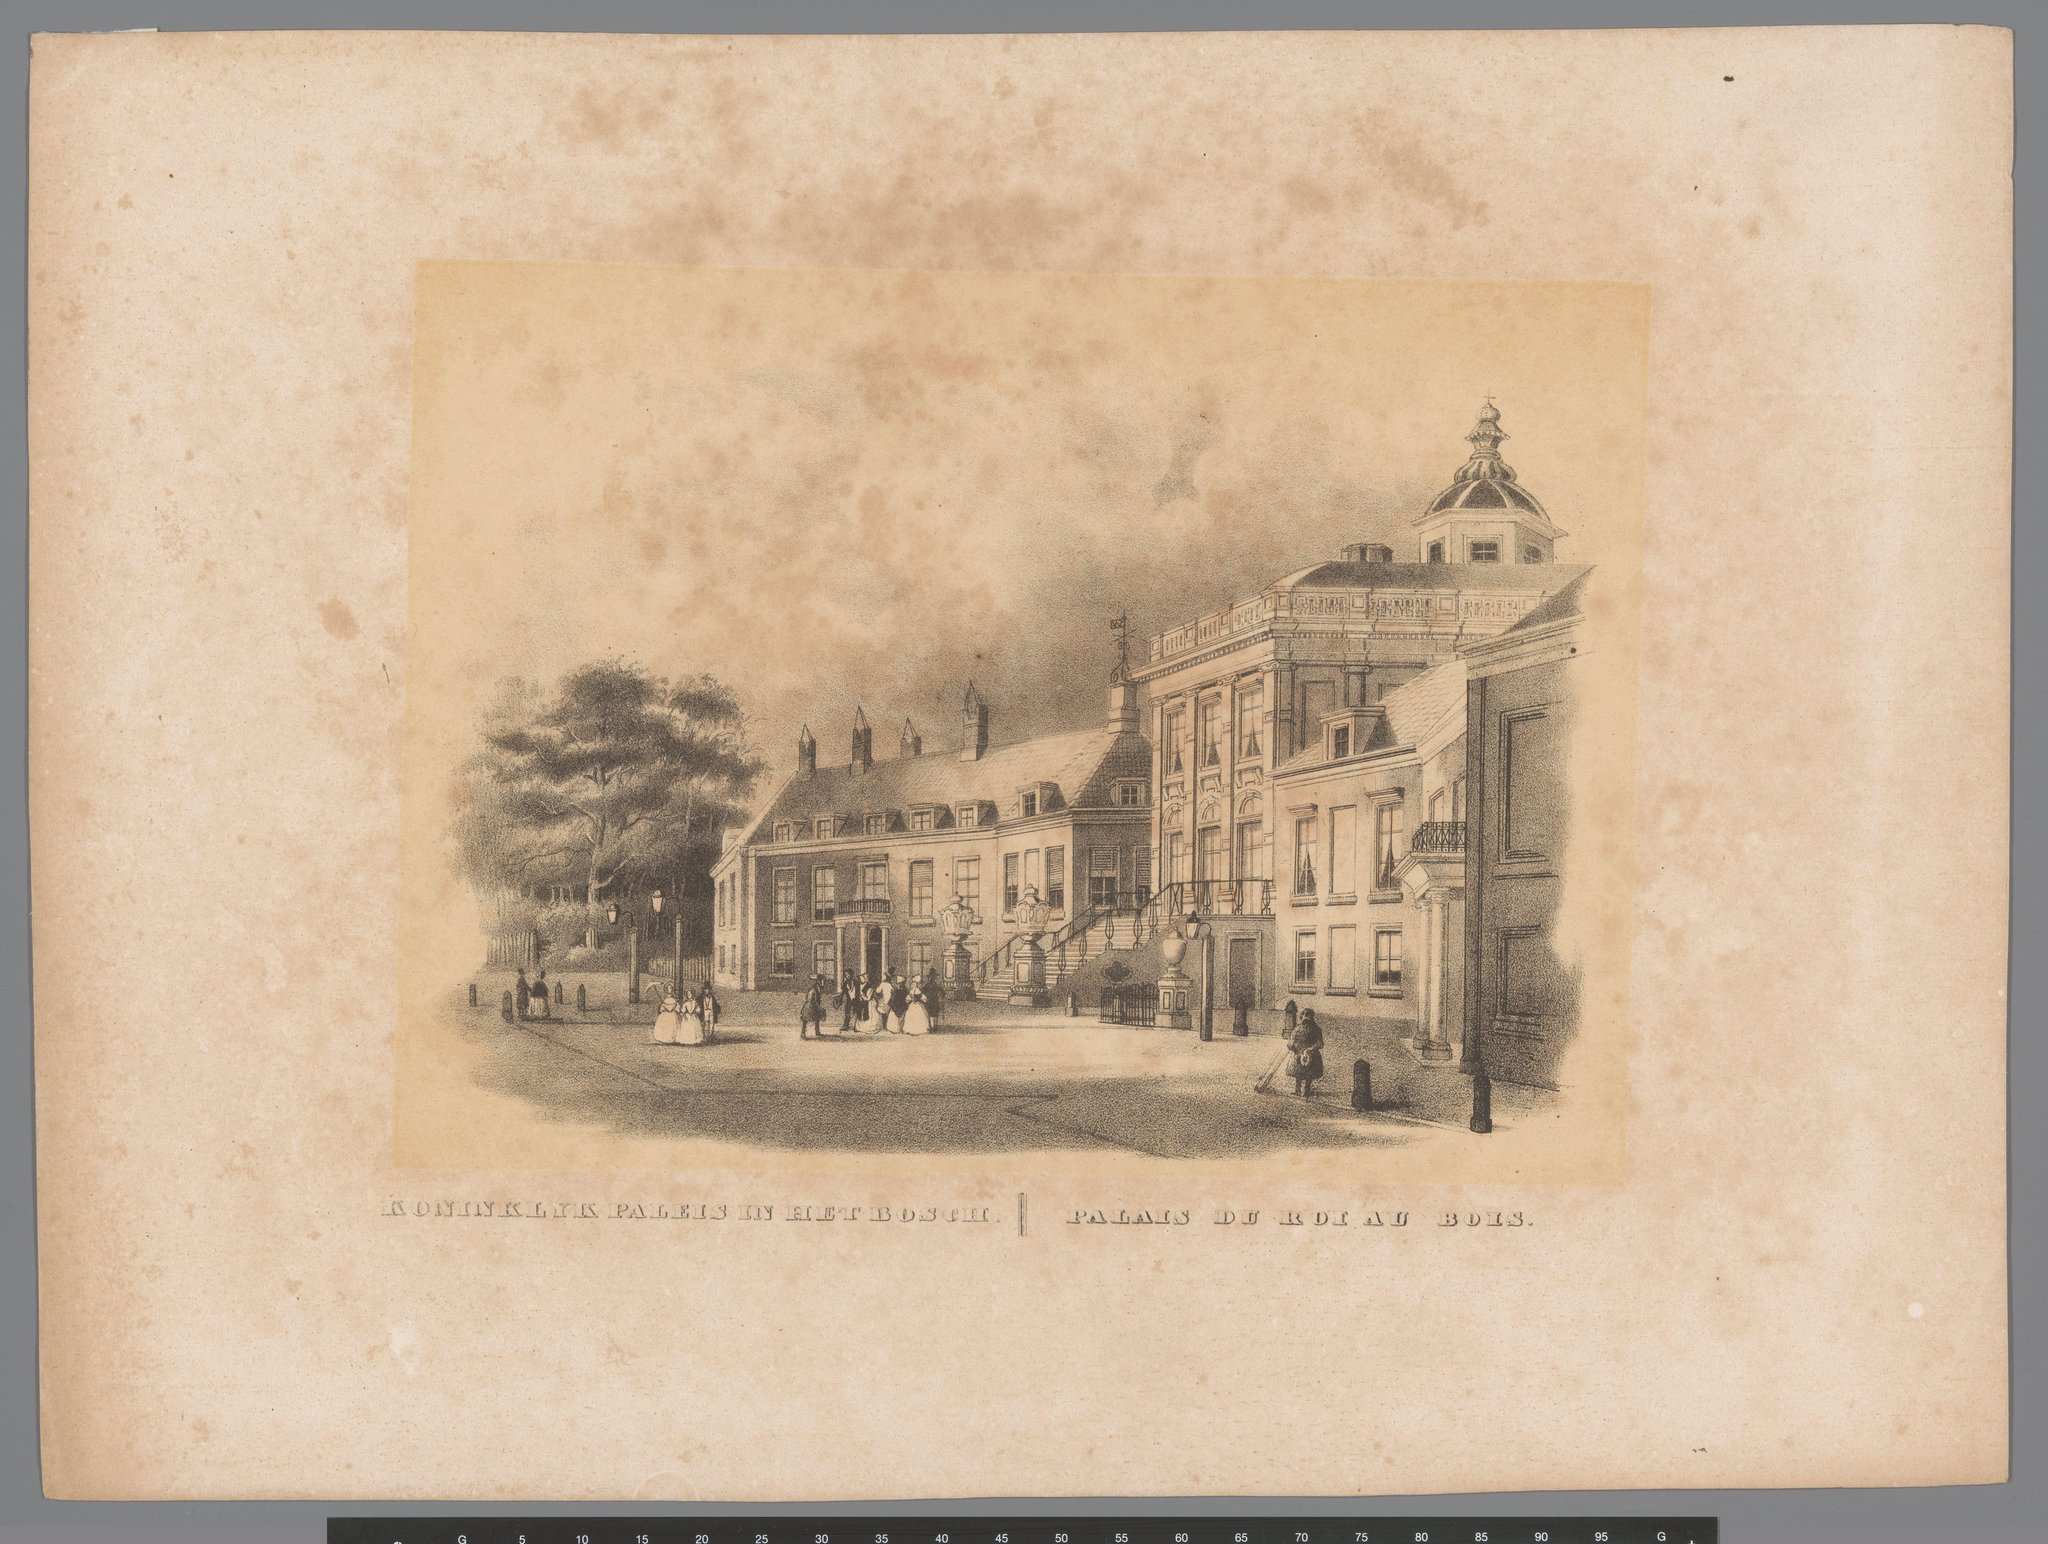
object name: print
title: Huis ten Bosch in Den Haag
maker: Anonymous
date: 1825-1875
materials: paper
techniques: tone lithography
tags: palace, the hague